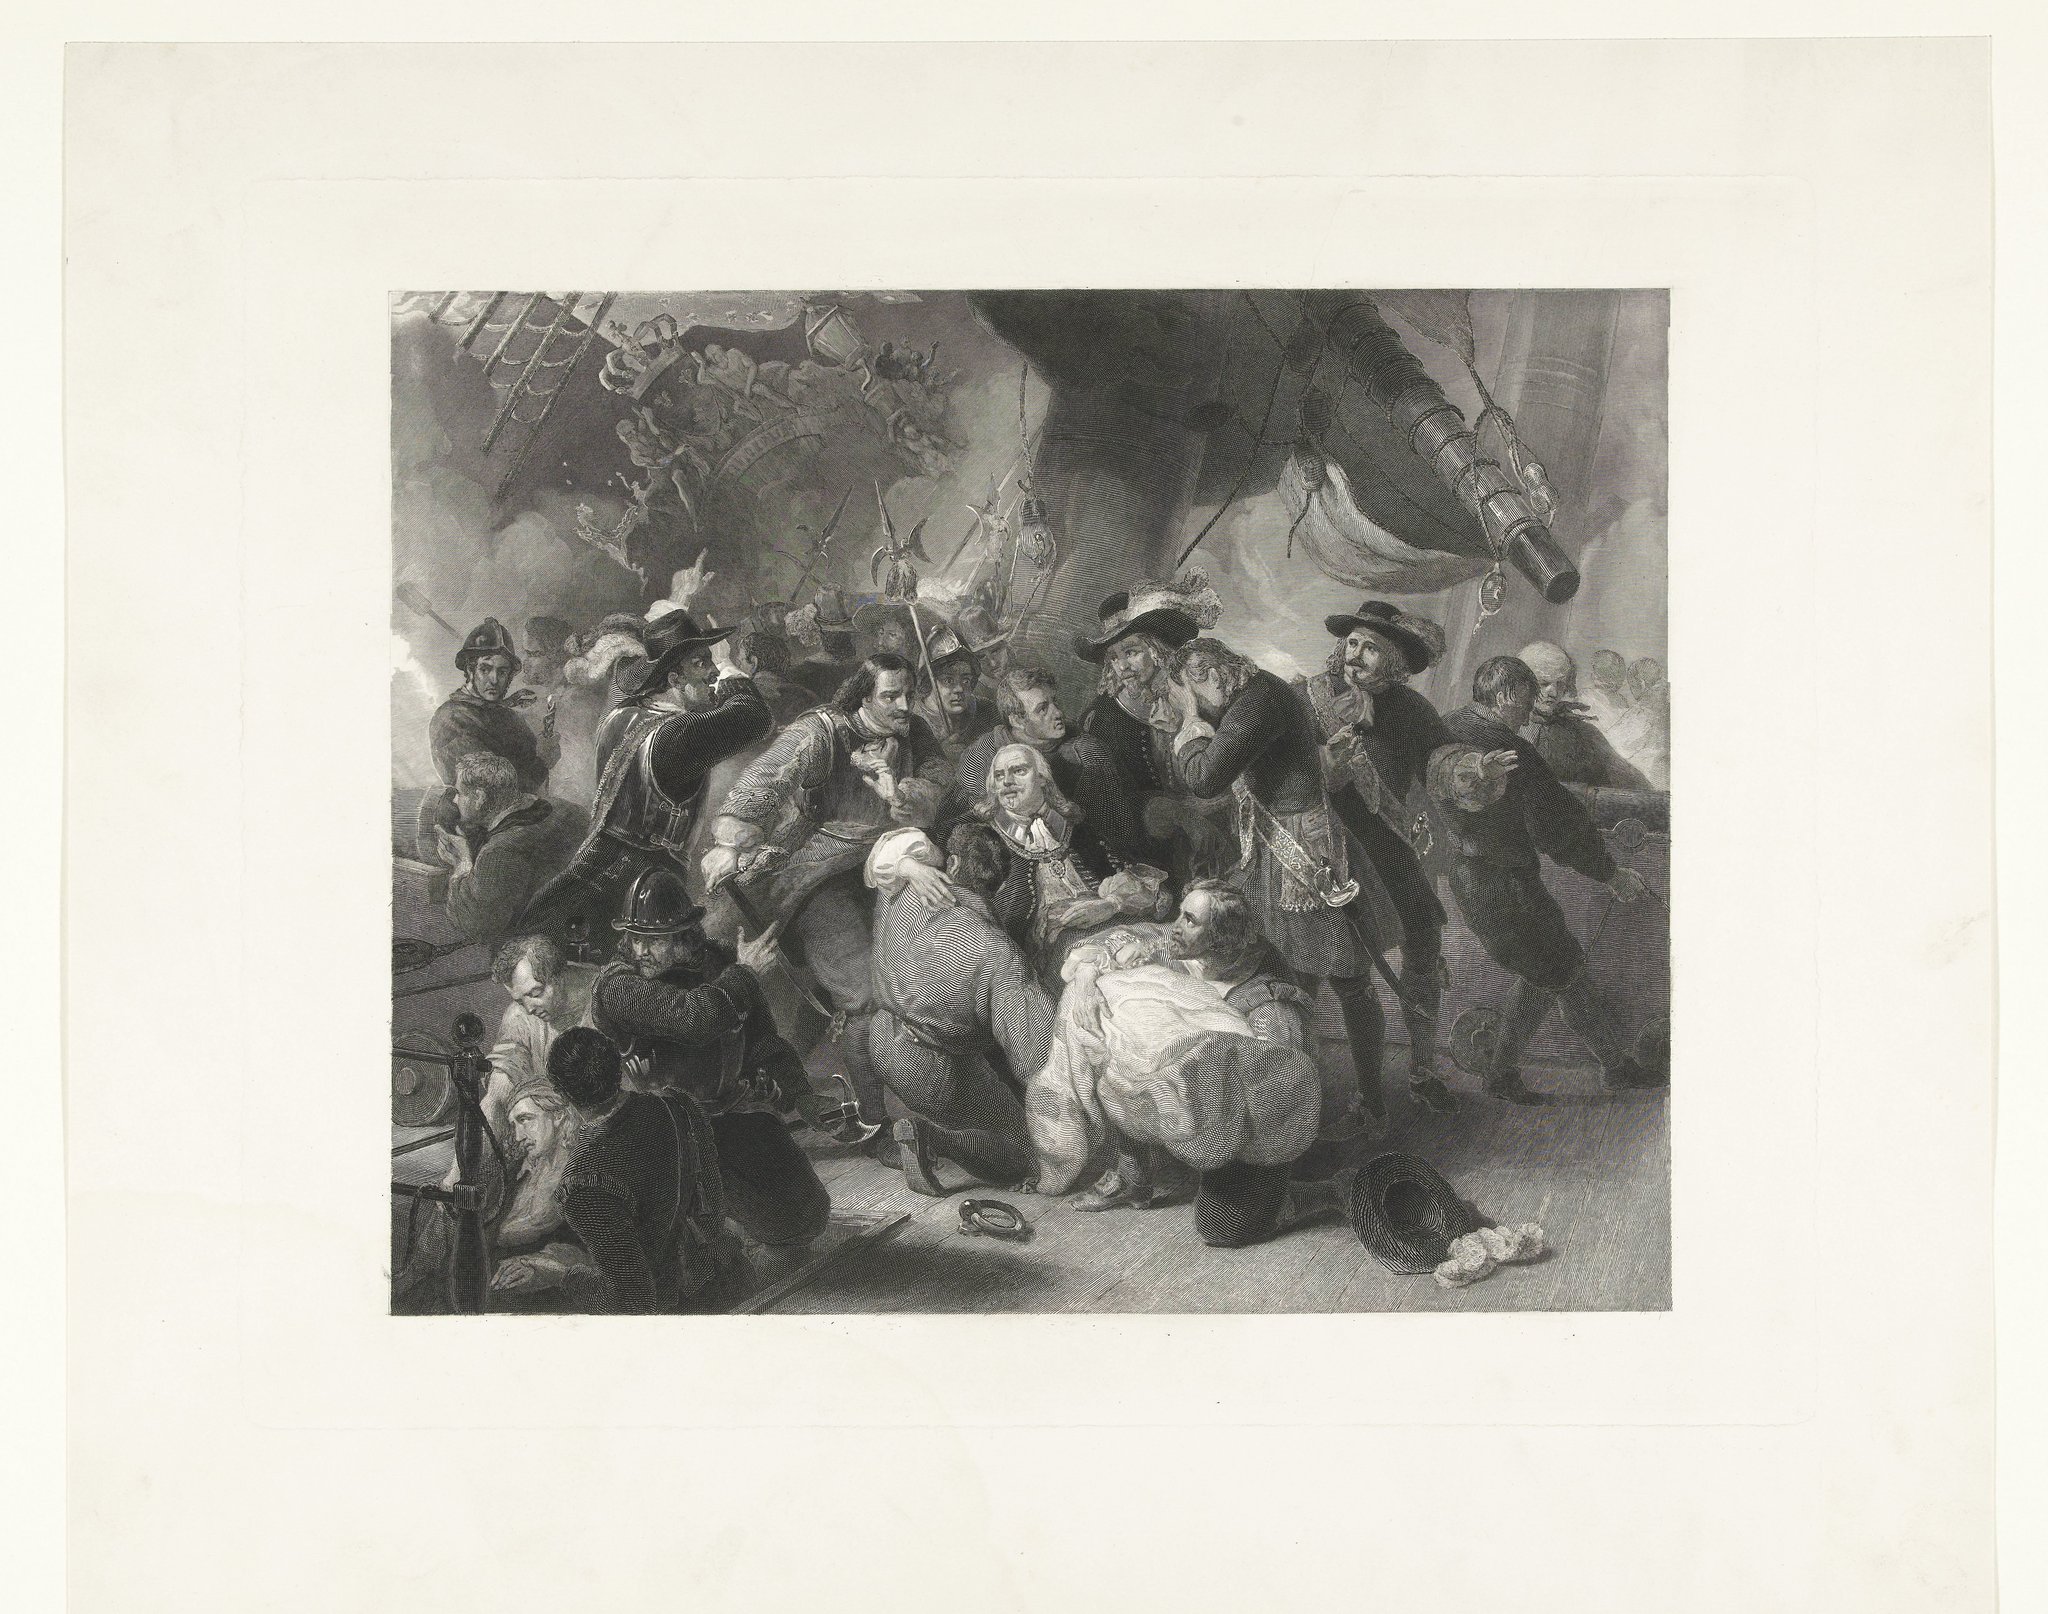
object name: history print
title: Admiraal Michiel Adriaenszoon de Ruyter raakt tijdens de zeeslag bij Agosta dodelijk gewond, 1676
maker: johann wilhelm kaiser (i)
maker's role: draughtsman, print maker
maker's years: 1813-1900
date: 1845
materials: paper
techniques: engraving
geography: netherlands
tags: flushing, michiel adriaenszoon de ruyter, medical aid and nursing of the sick and wounded, battle (+ naval force), battle of augusta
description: Admiraal Michiel Adriaenszoon de Ruyter raakt dodelijk gewond tijdens de zeeslag bij Agosta op 22 april 1676 tussen een gecombineerd Hollands-Spaanse vloot onder De Ruyter en een Franse vloot onder Abraham Duquesne. In alle hevigheid van de slag wordt De Ruyter wordt door zijn bemanning in een laken gewikkeld en naar zijn kajuit gedragen.